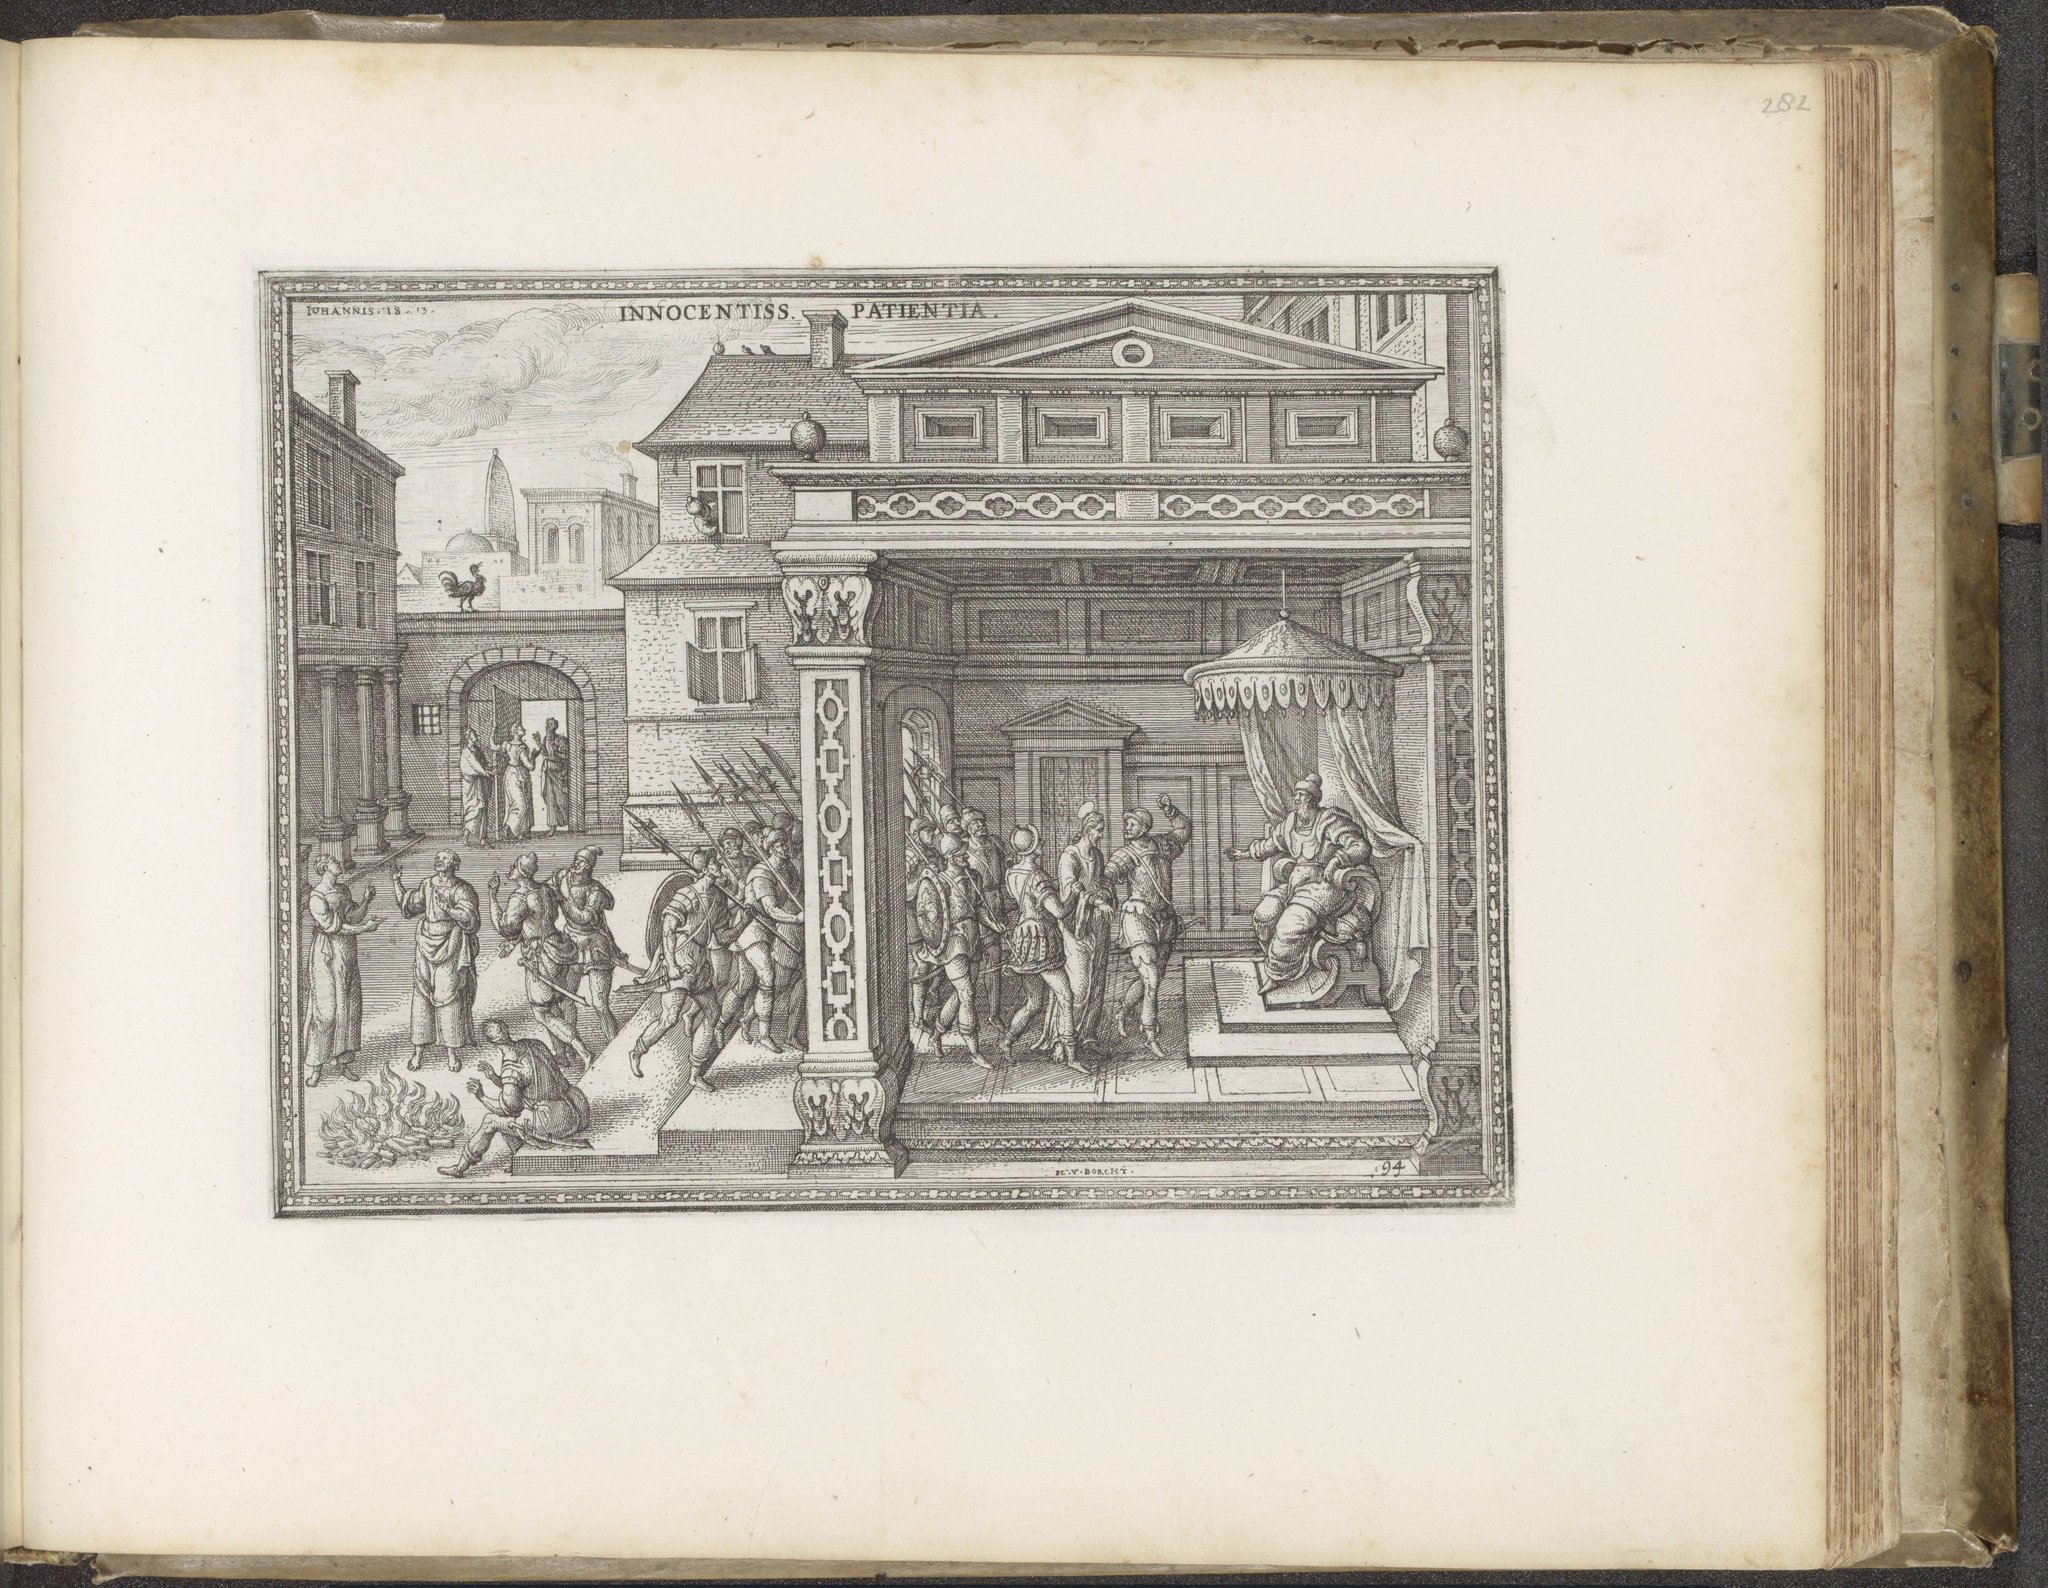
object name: print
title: Innocentiss. patientia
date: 1582-1593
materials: paper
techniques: etching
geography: amsterdam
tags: christ before annas (hanna); maybe a soldier about to strike christ (john 18:13, 18:19-24), repentance of peter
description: Christus wordt door een groep soldaten voorgeleid aan een man op een troon (Annas). Links op de binnenplaats de verloochening van Petrus (Joh. 18). De prent maakt deel uit van een album.